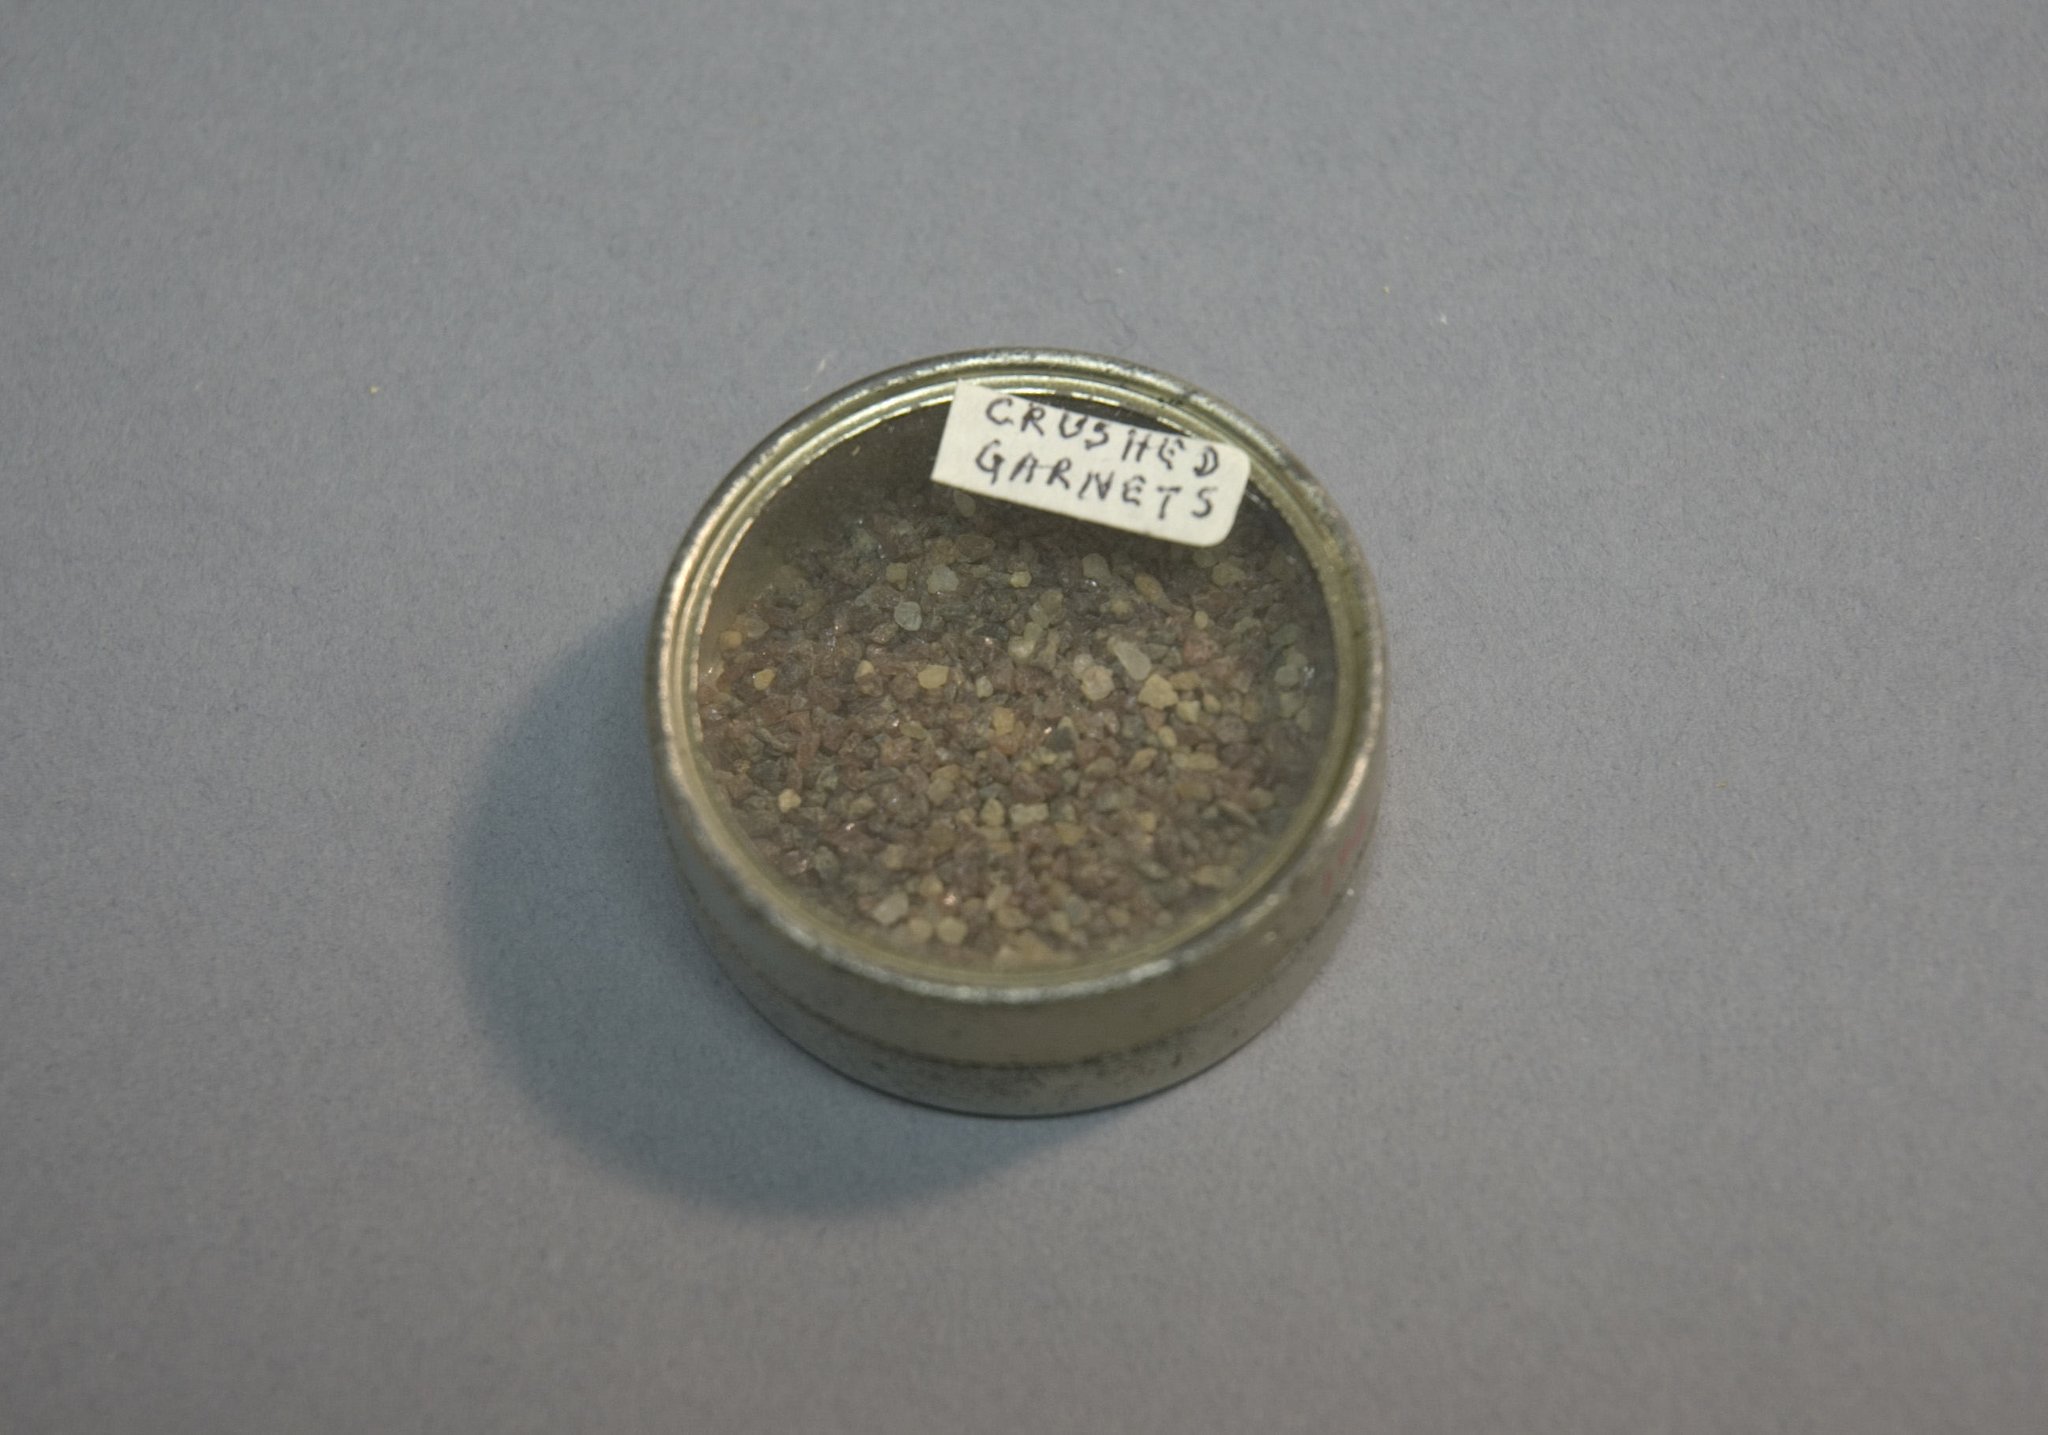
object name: jade carving material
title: Container of Crushed Garnets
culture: chinese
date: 1901-2000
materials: gemstone